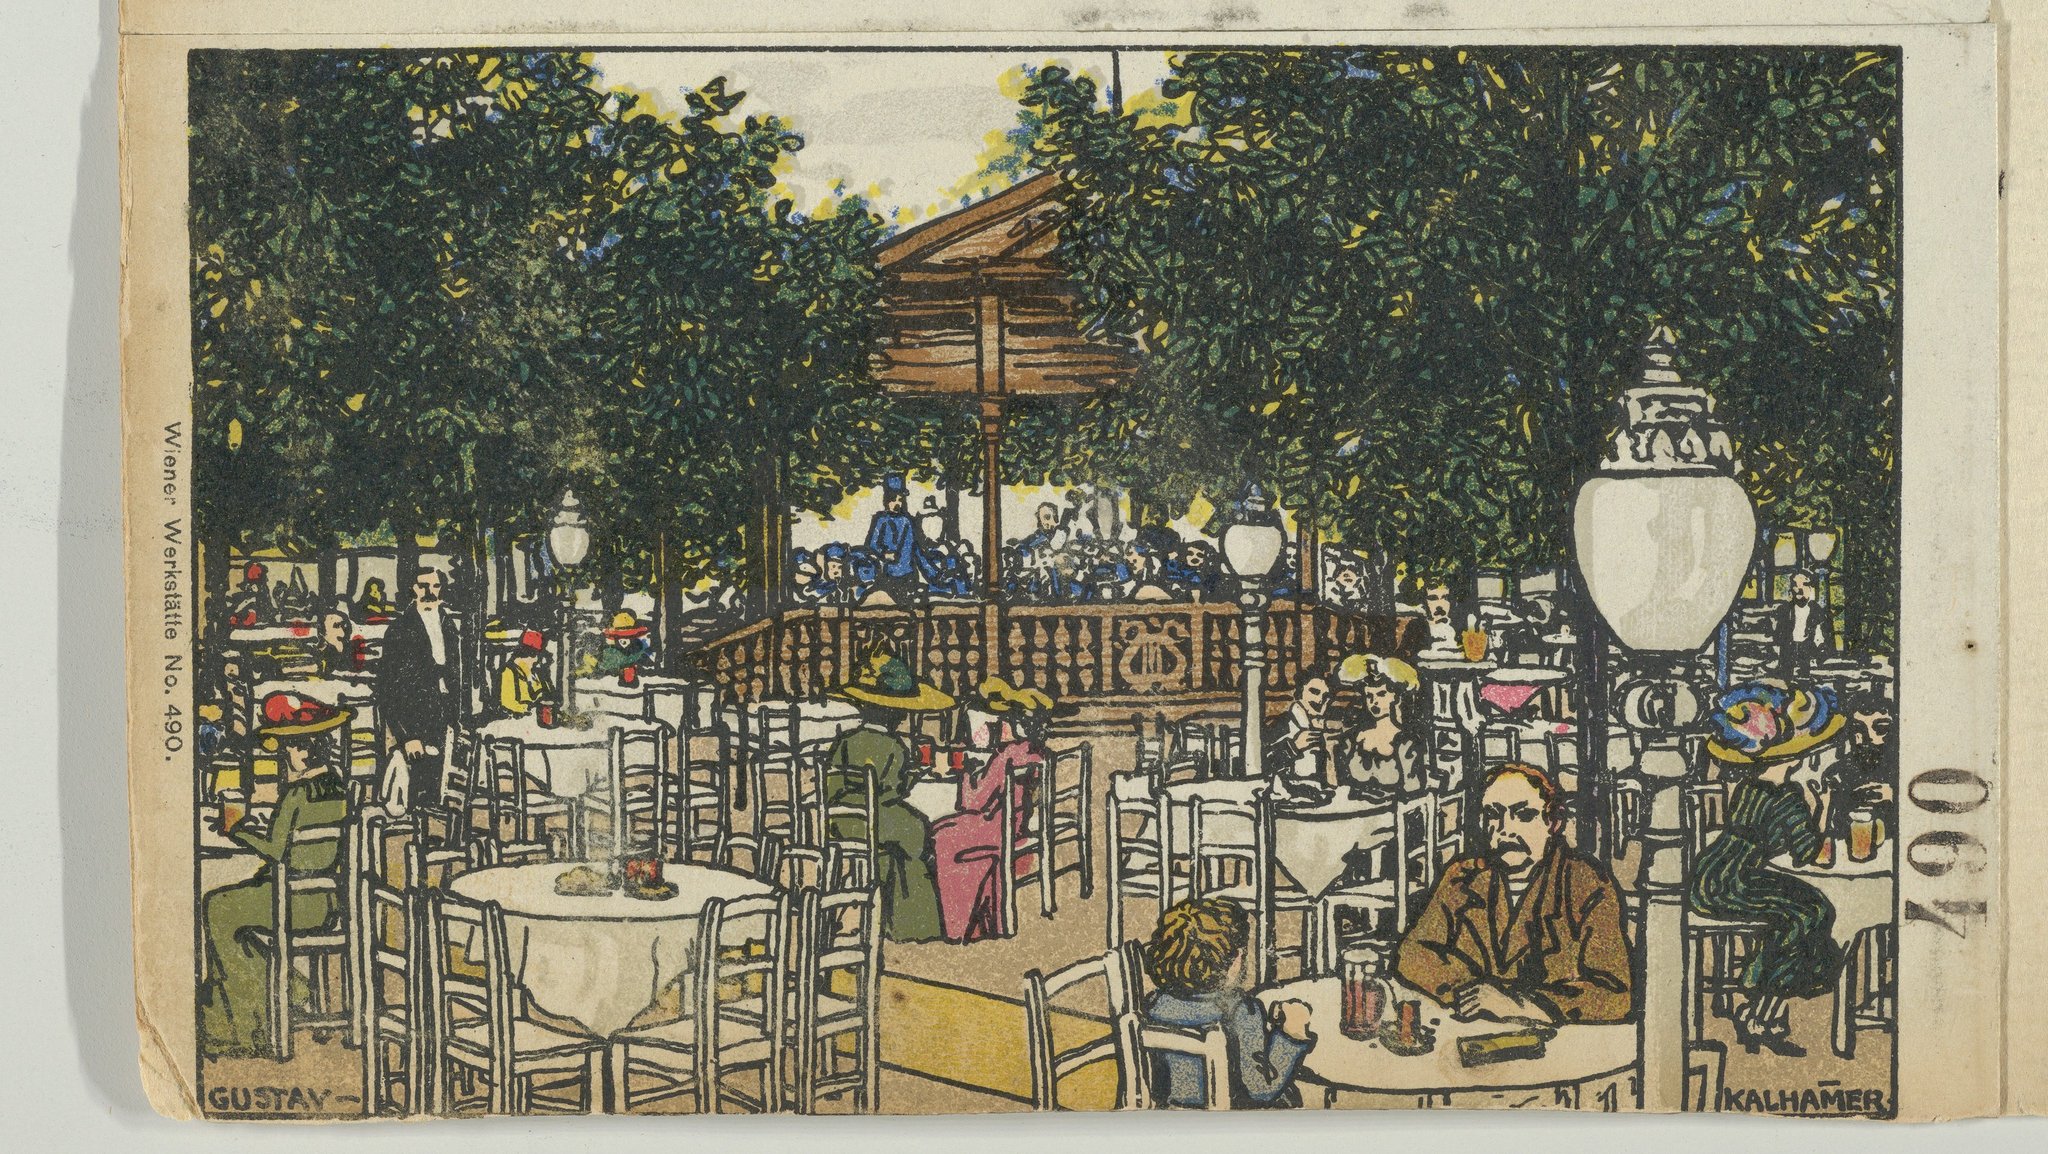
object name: print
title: Hüttledorf Brewery, A. Brusatti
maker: gustav kalhammer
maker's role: artist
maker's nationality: austrian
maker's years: 1886-1919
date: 1912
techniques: lithograph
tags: men,women,chairs,tables